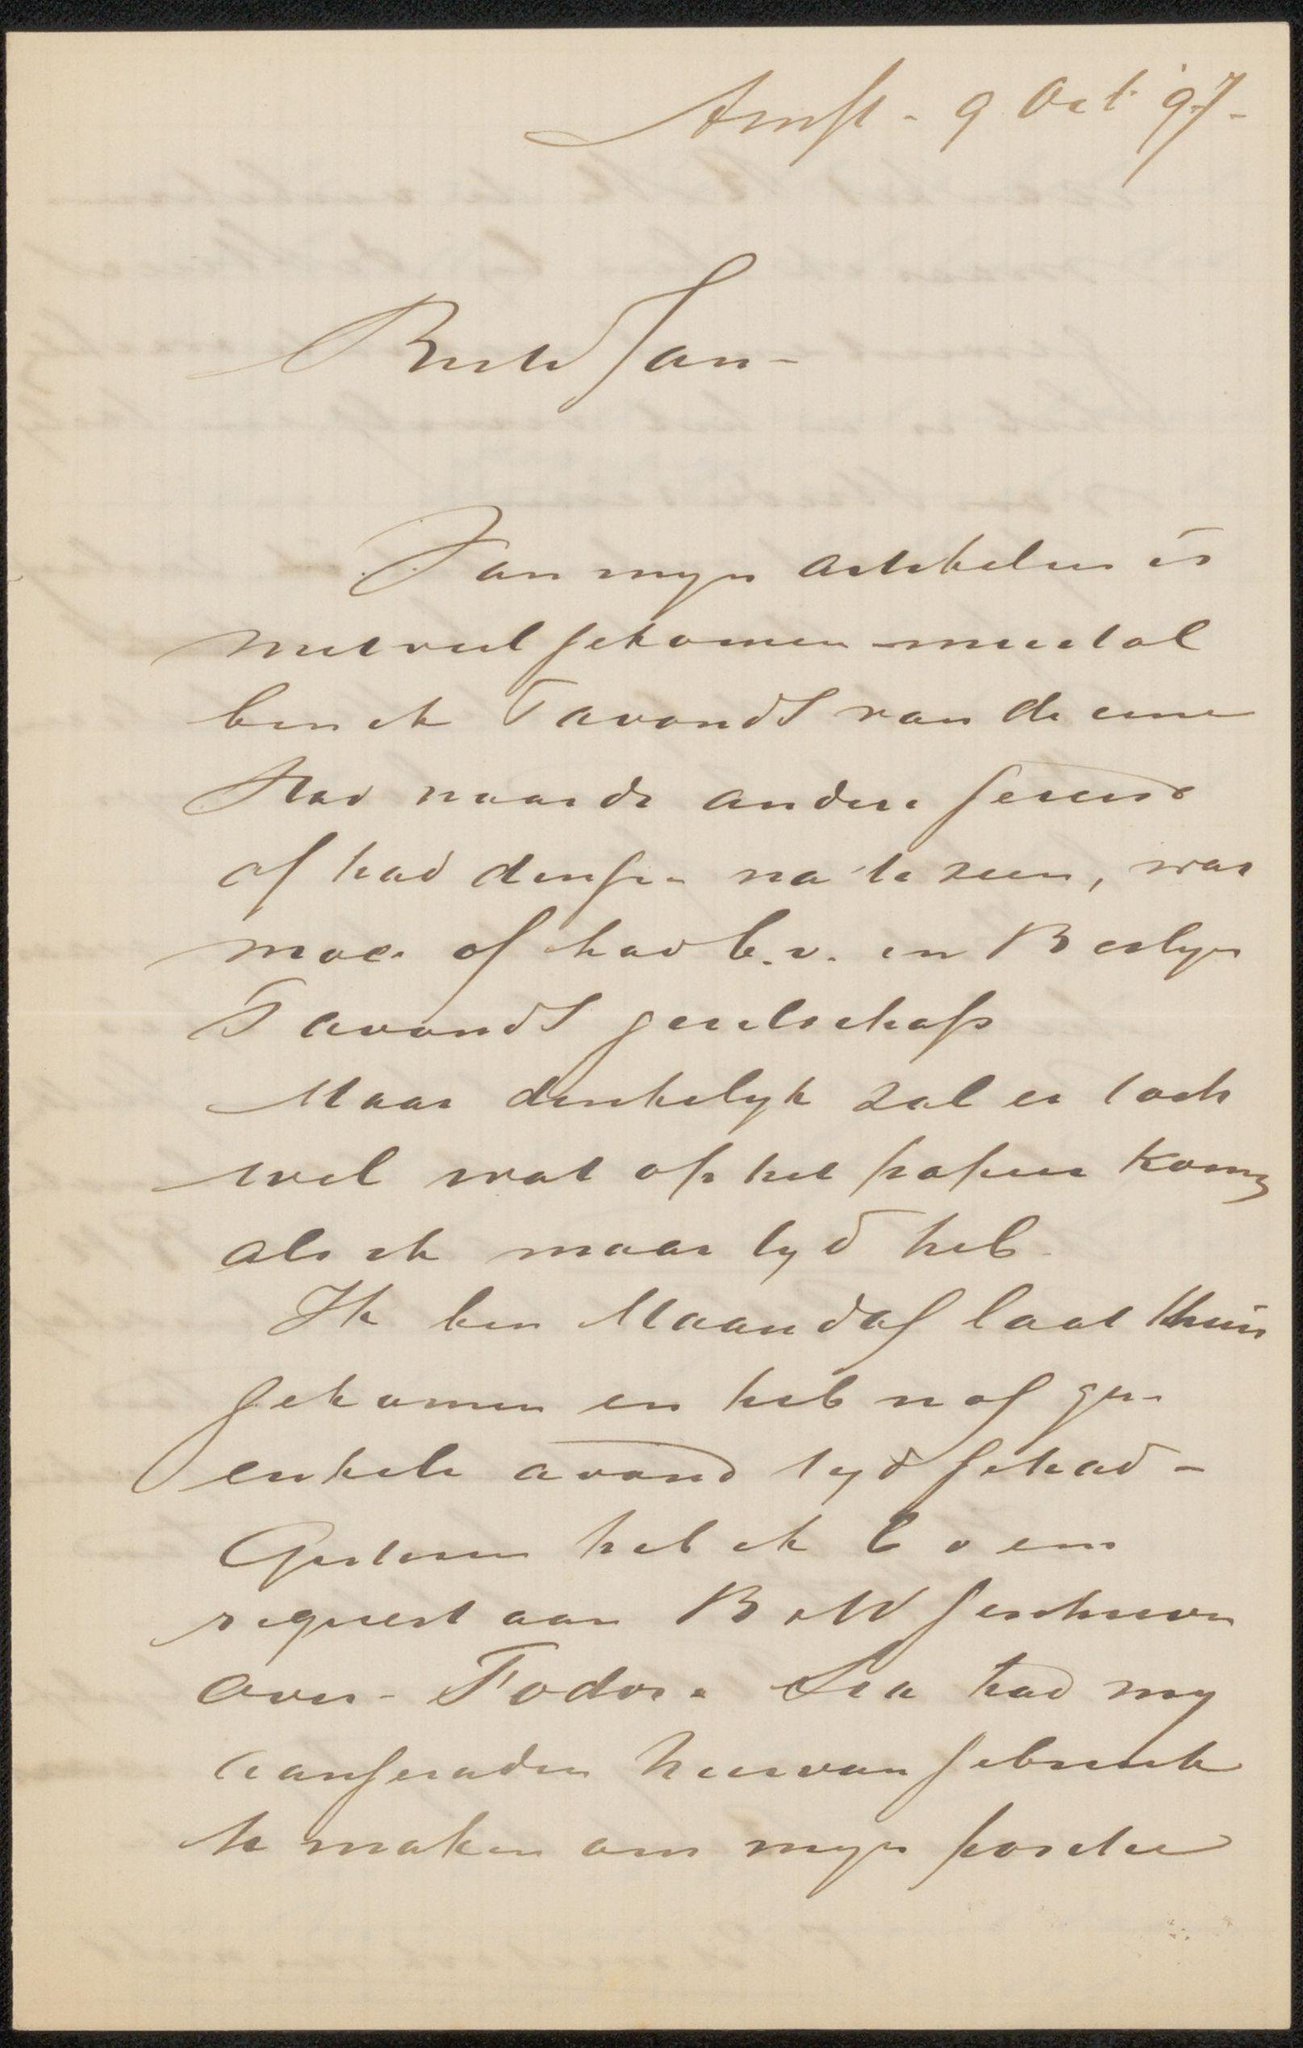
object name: letter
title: Brief aan Jan Veth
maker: cornelis gerardus t hooft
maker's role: draughtsman, painter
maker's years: 1866-1936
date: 1897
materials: ink, paper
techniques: pen, writing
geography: amsterdam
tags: dordrecht, painter, draughtsman, designer, jan veth, maastricht, jonkheer victor eugène louis de stuers, the hague, nijmegen, print maker, adriaan pit, richard nicolaüs roland holst, rijksmuseum amsterdam, painting (including book-illumination, miniature-painting), printed matter, berlin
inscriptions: collector's mark: ‘RPK’